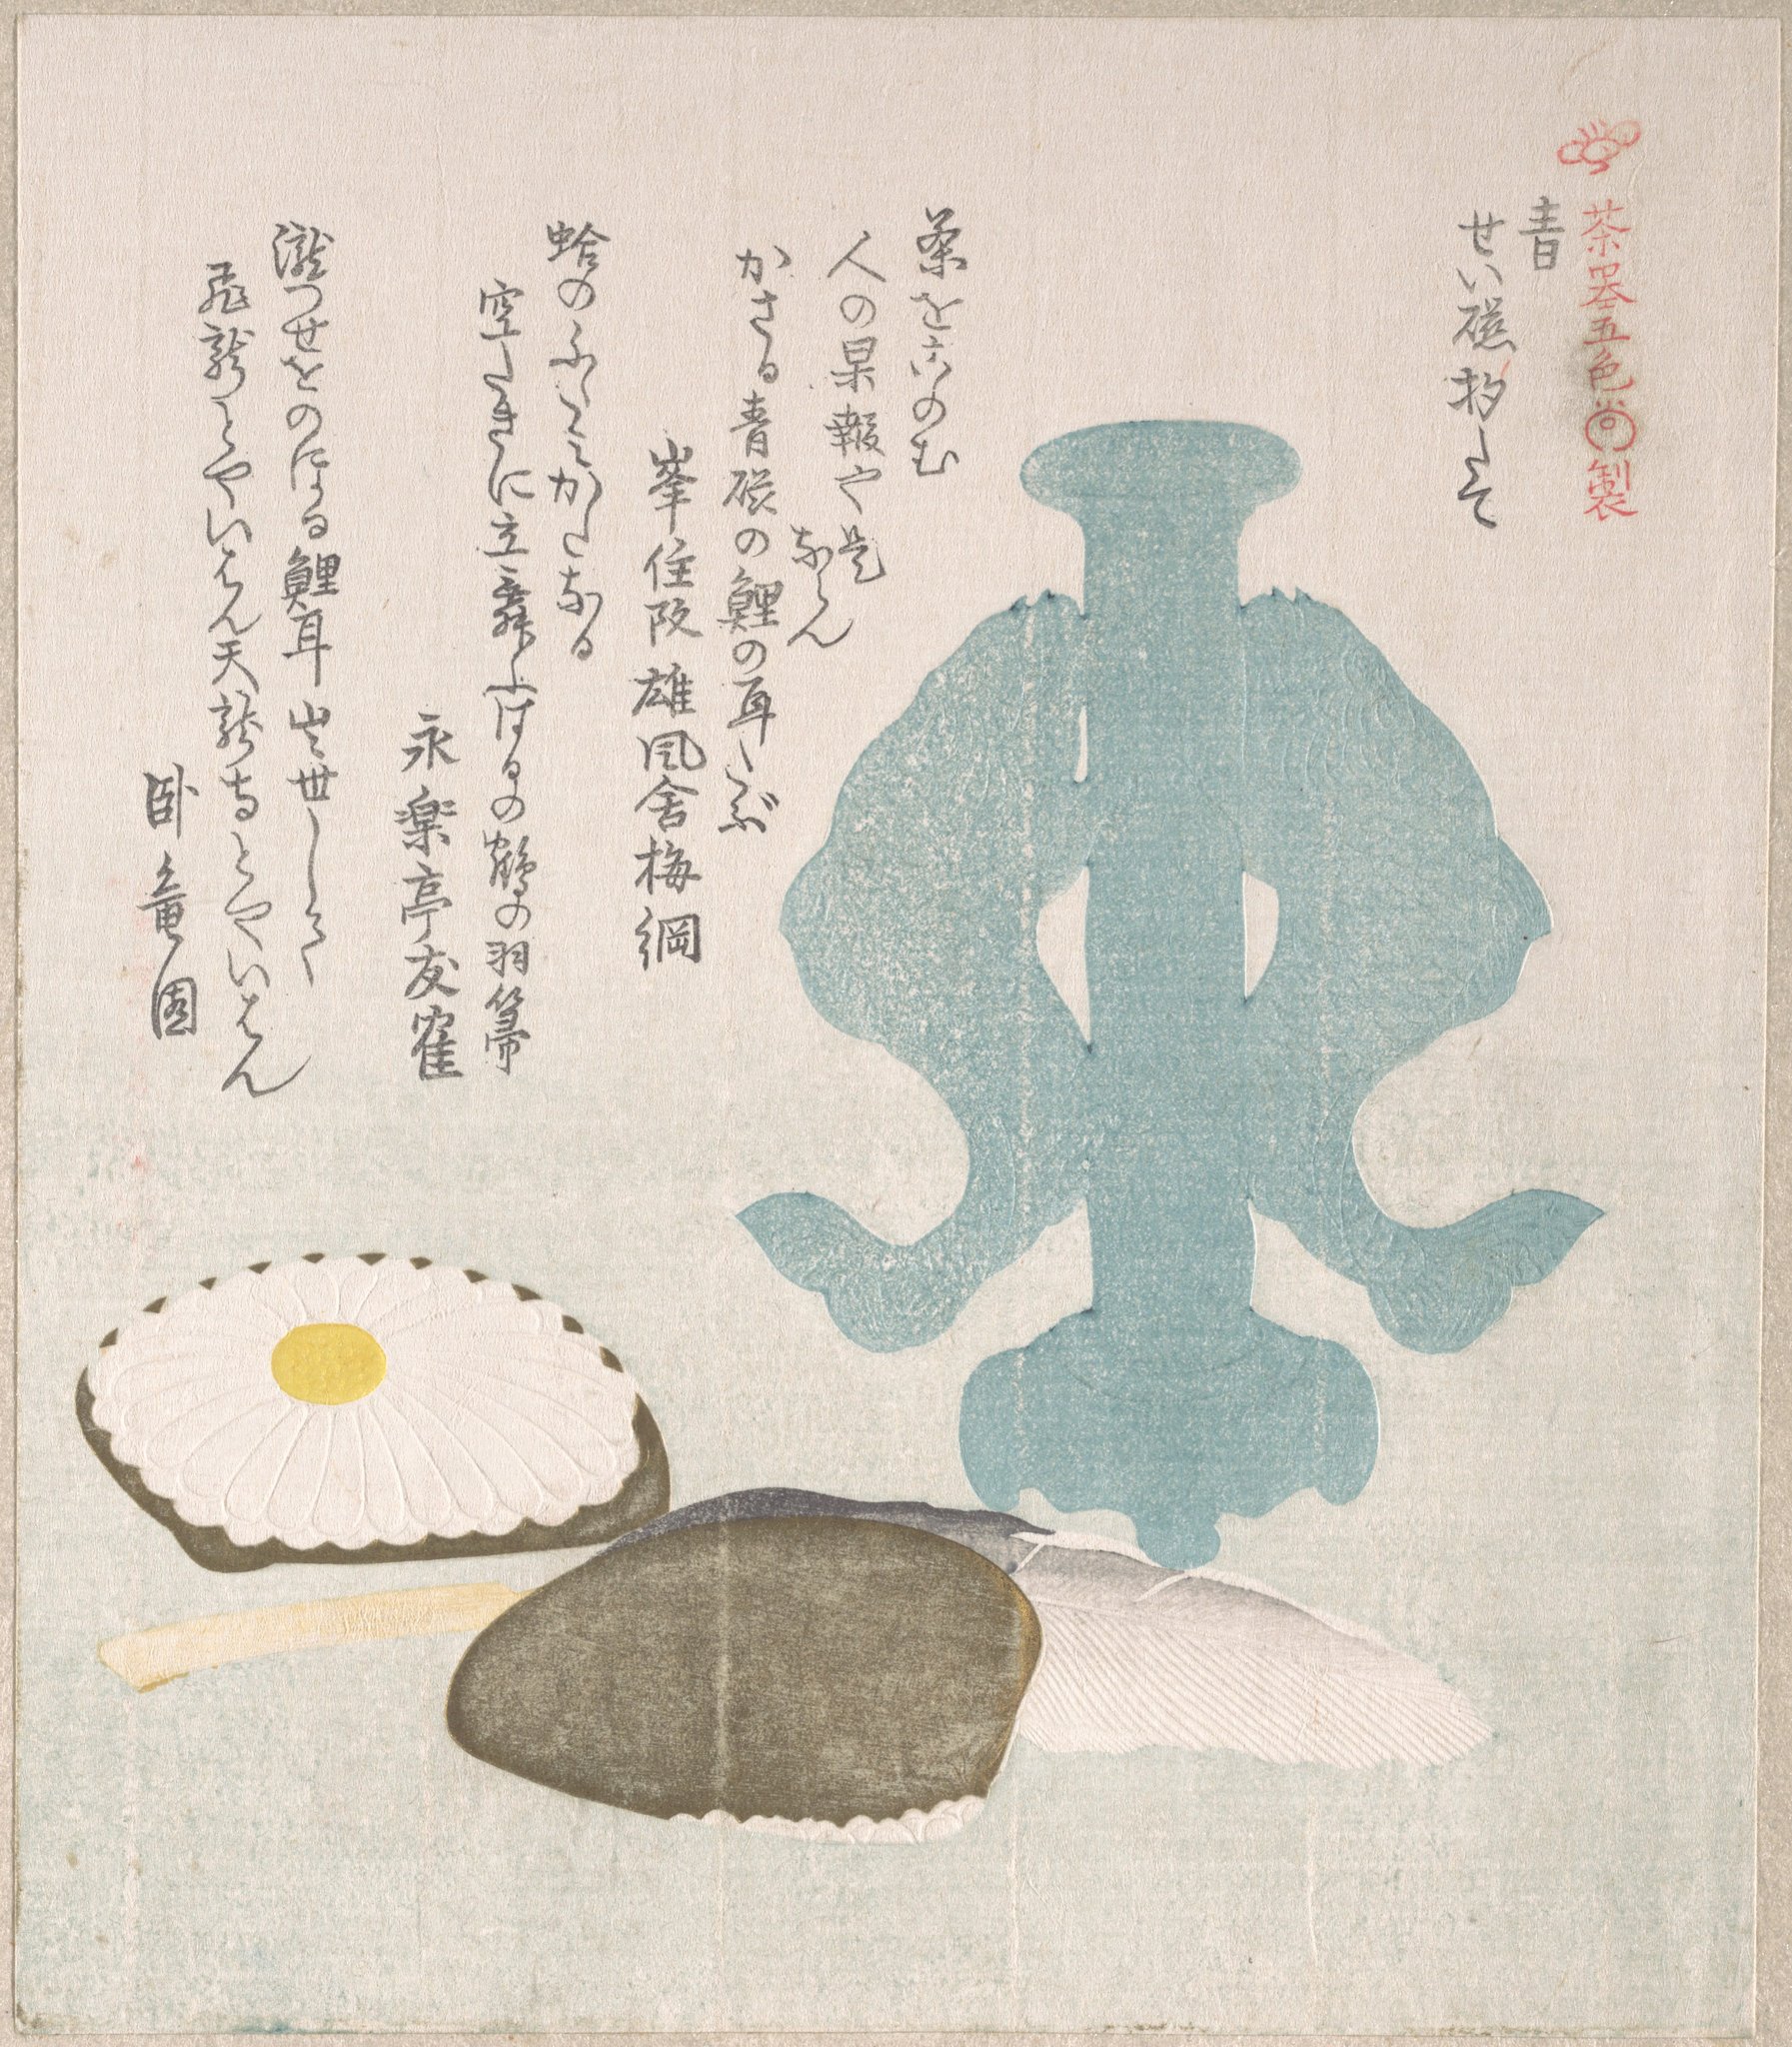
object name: print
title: Blue; Dipper-holder of Celadon and Other Objects for the Tea Ceremony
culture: japanese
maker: kubo shunman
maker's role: artist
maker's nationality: japanese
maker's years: 1757-1820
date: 1801-1900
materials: ink, paper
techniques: surimono, woodblock print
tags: fish